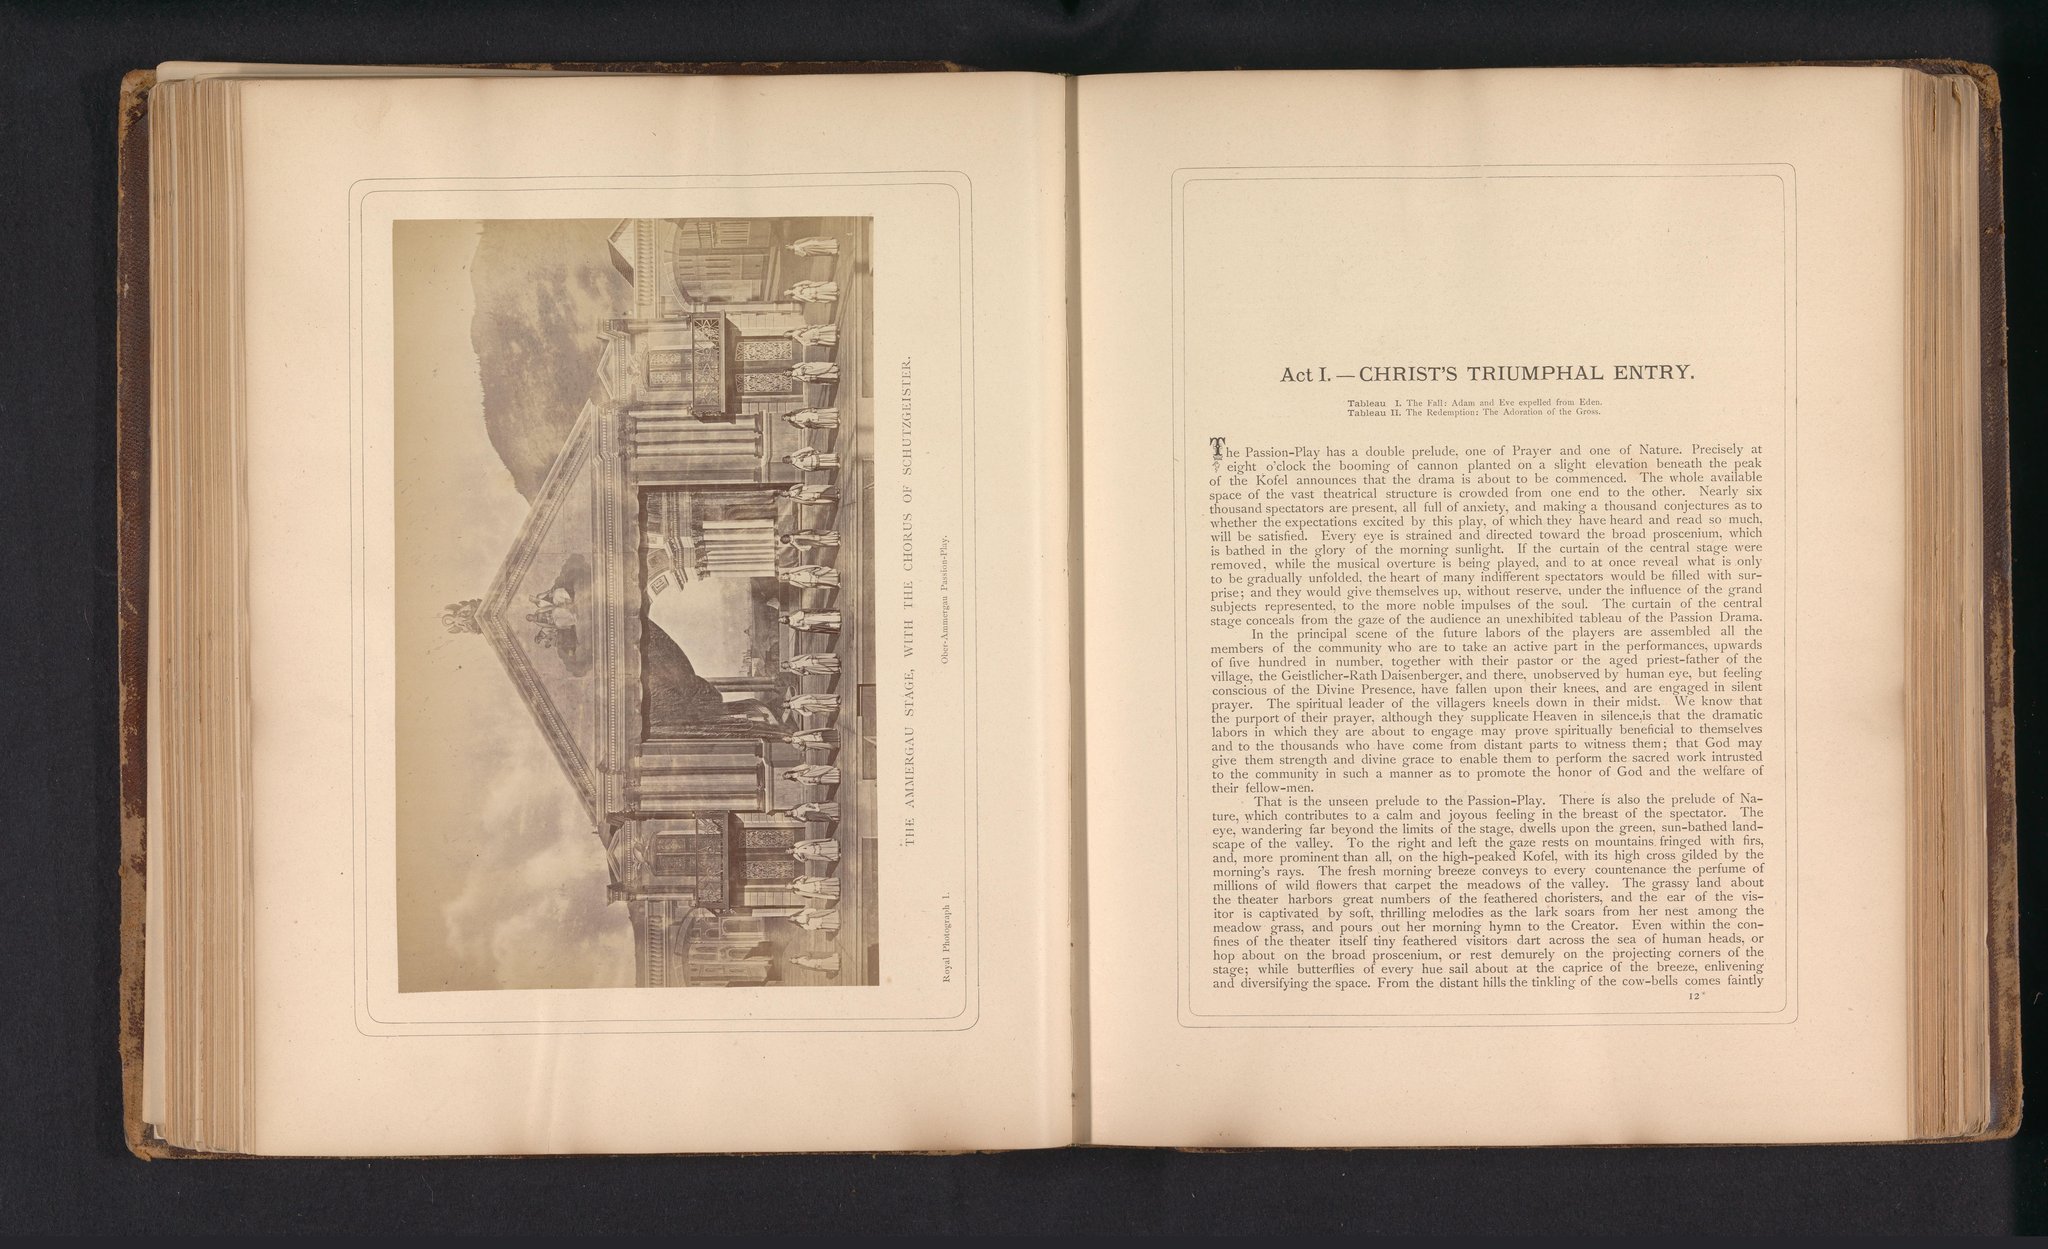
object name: photograph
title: The Ammergau stage, with the chorus of Schützgeister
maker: joseph albert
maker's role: printer, publisher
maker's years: 1825-1886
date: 1868-1873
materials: photographic support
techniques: albumen print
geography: oberammergau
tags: group of actors, troupe; actors on the stage, choir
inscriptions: number: ‘Royal Photograph 1.’